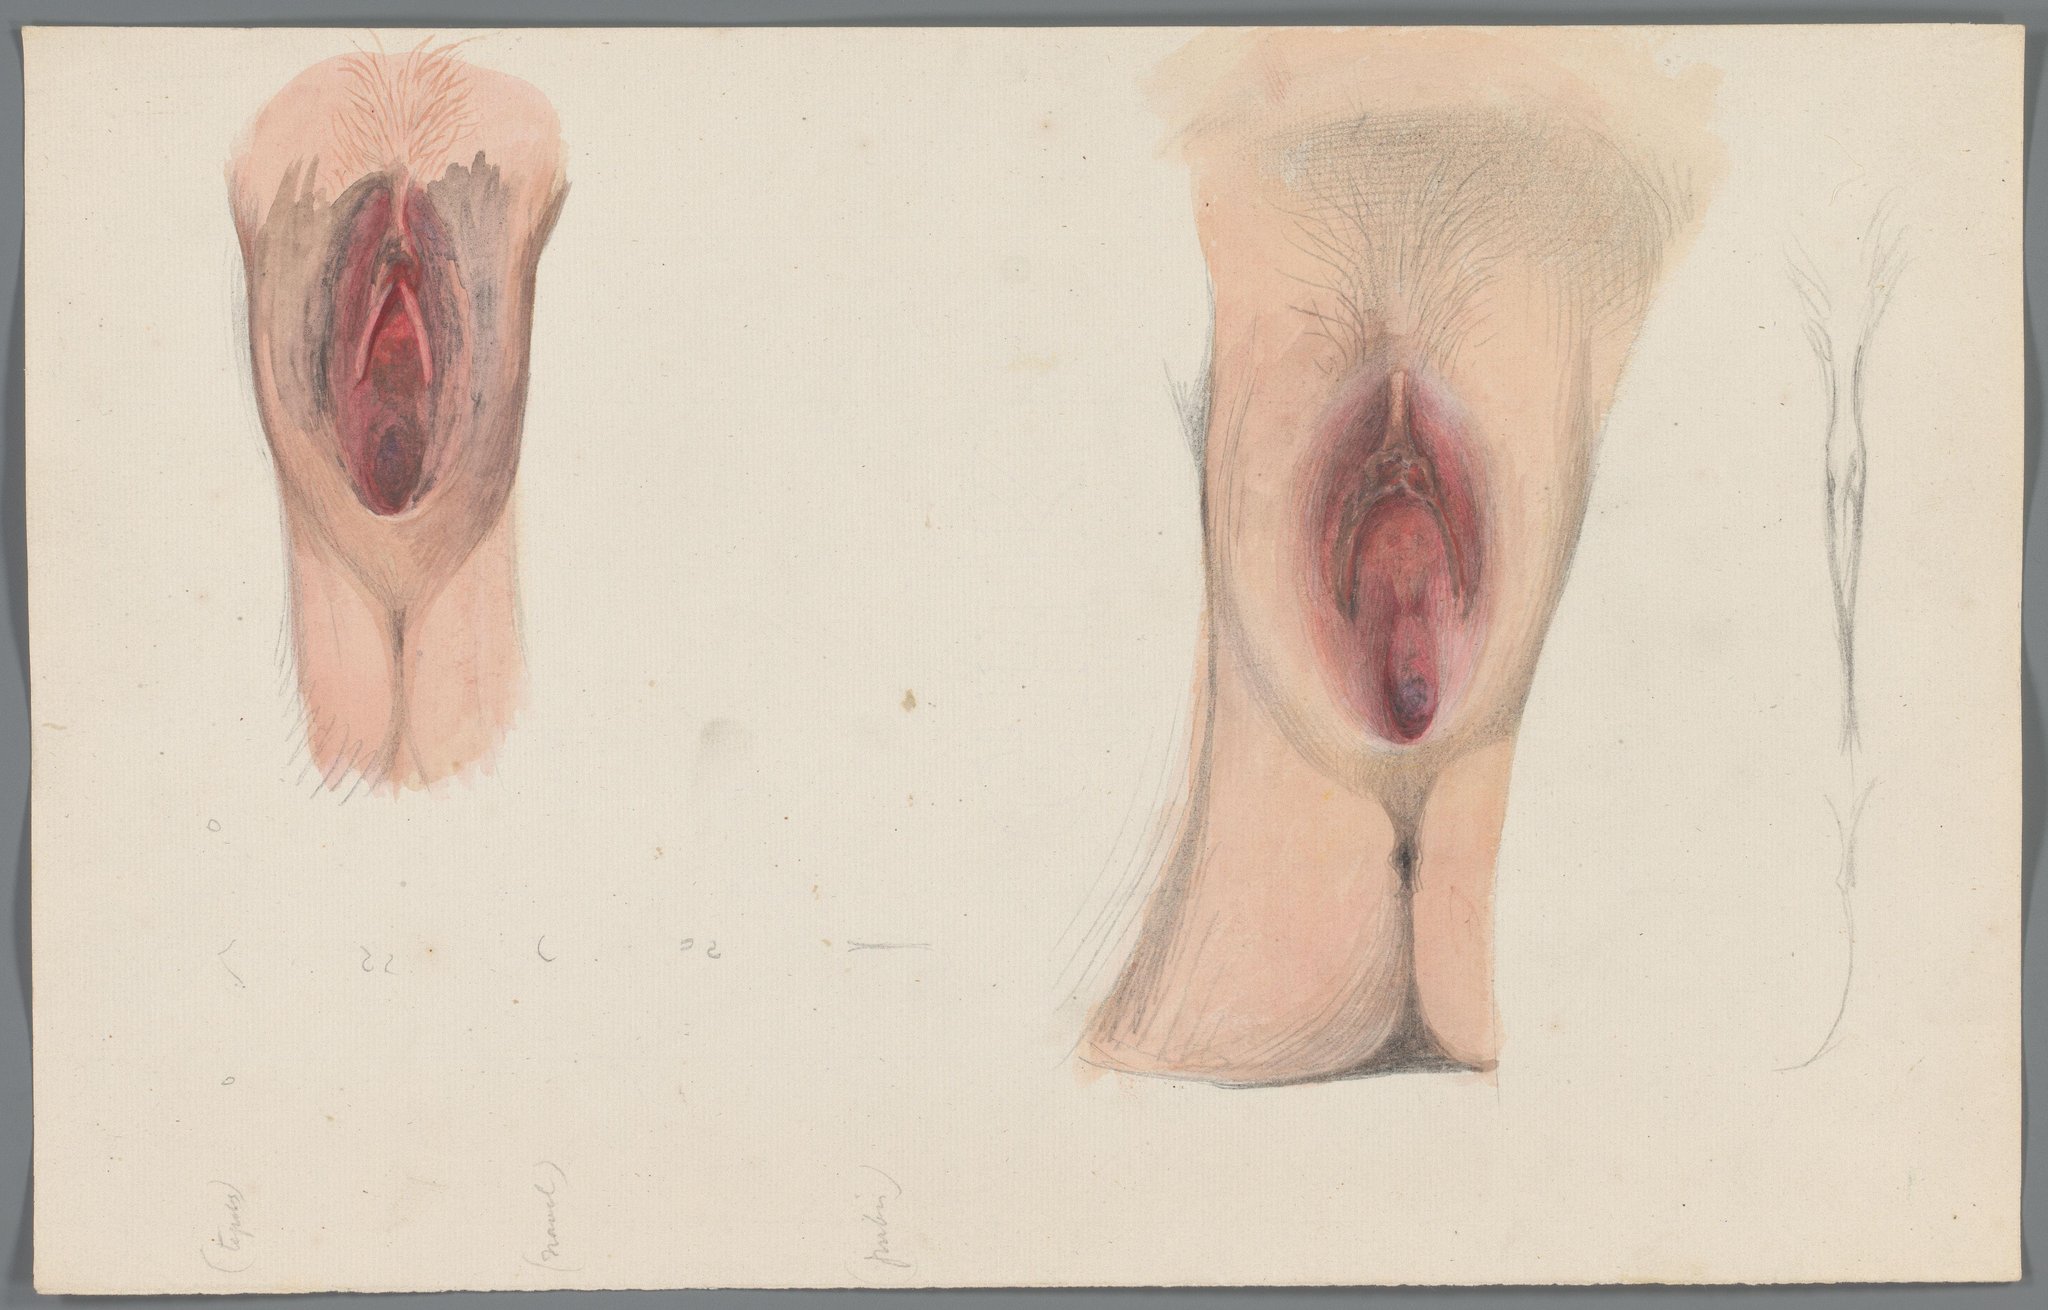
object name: drawing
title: Studies van vulva's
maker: jacobus everhardus josephus van den berg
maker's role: draughtsman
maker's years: 1802-1861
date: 1812-1861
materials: paper, pencil, watercolor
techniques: brush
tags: female sexual organs